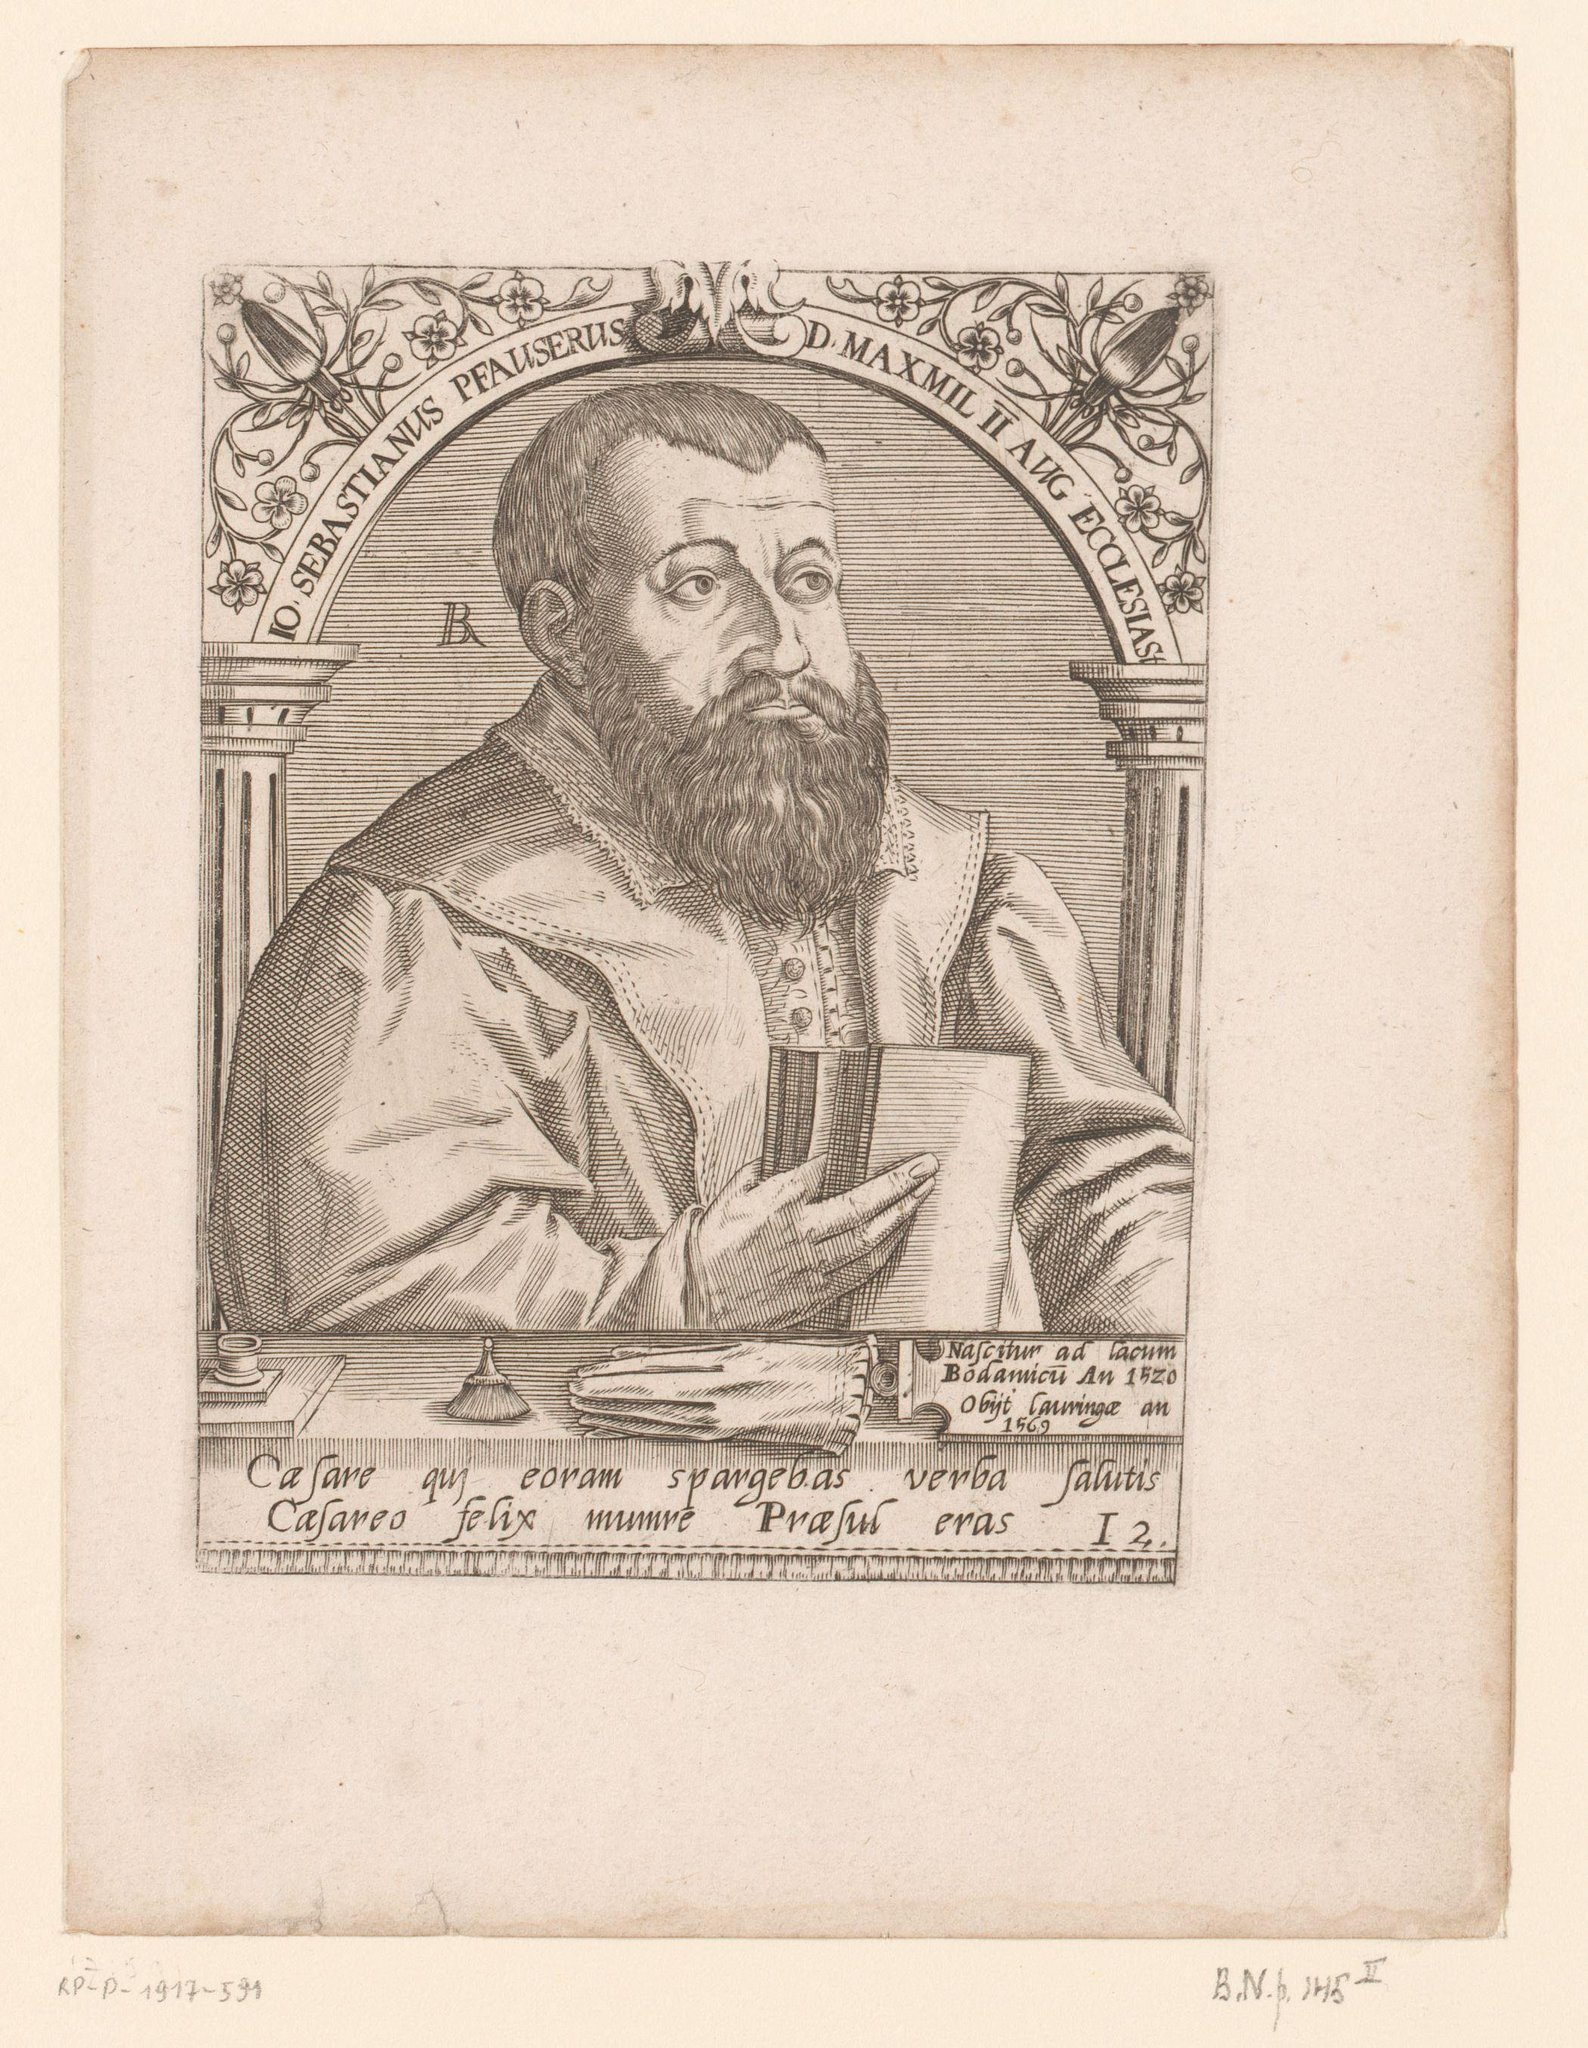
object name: print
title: Jo. Sebastianus Pfauserus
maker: robert boissard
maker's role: print maker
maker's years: 1570-1611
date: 1597-1599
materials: paper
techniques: engraving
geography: france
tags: gloves, mittens, etc., historical persons, book, insects: beetle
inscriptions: collector's mark: Lugt 2228